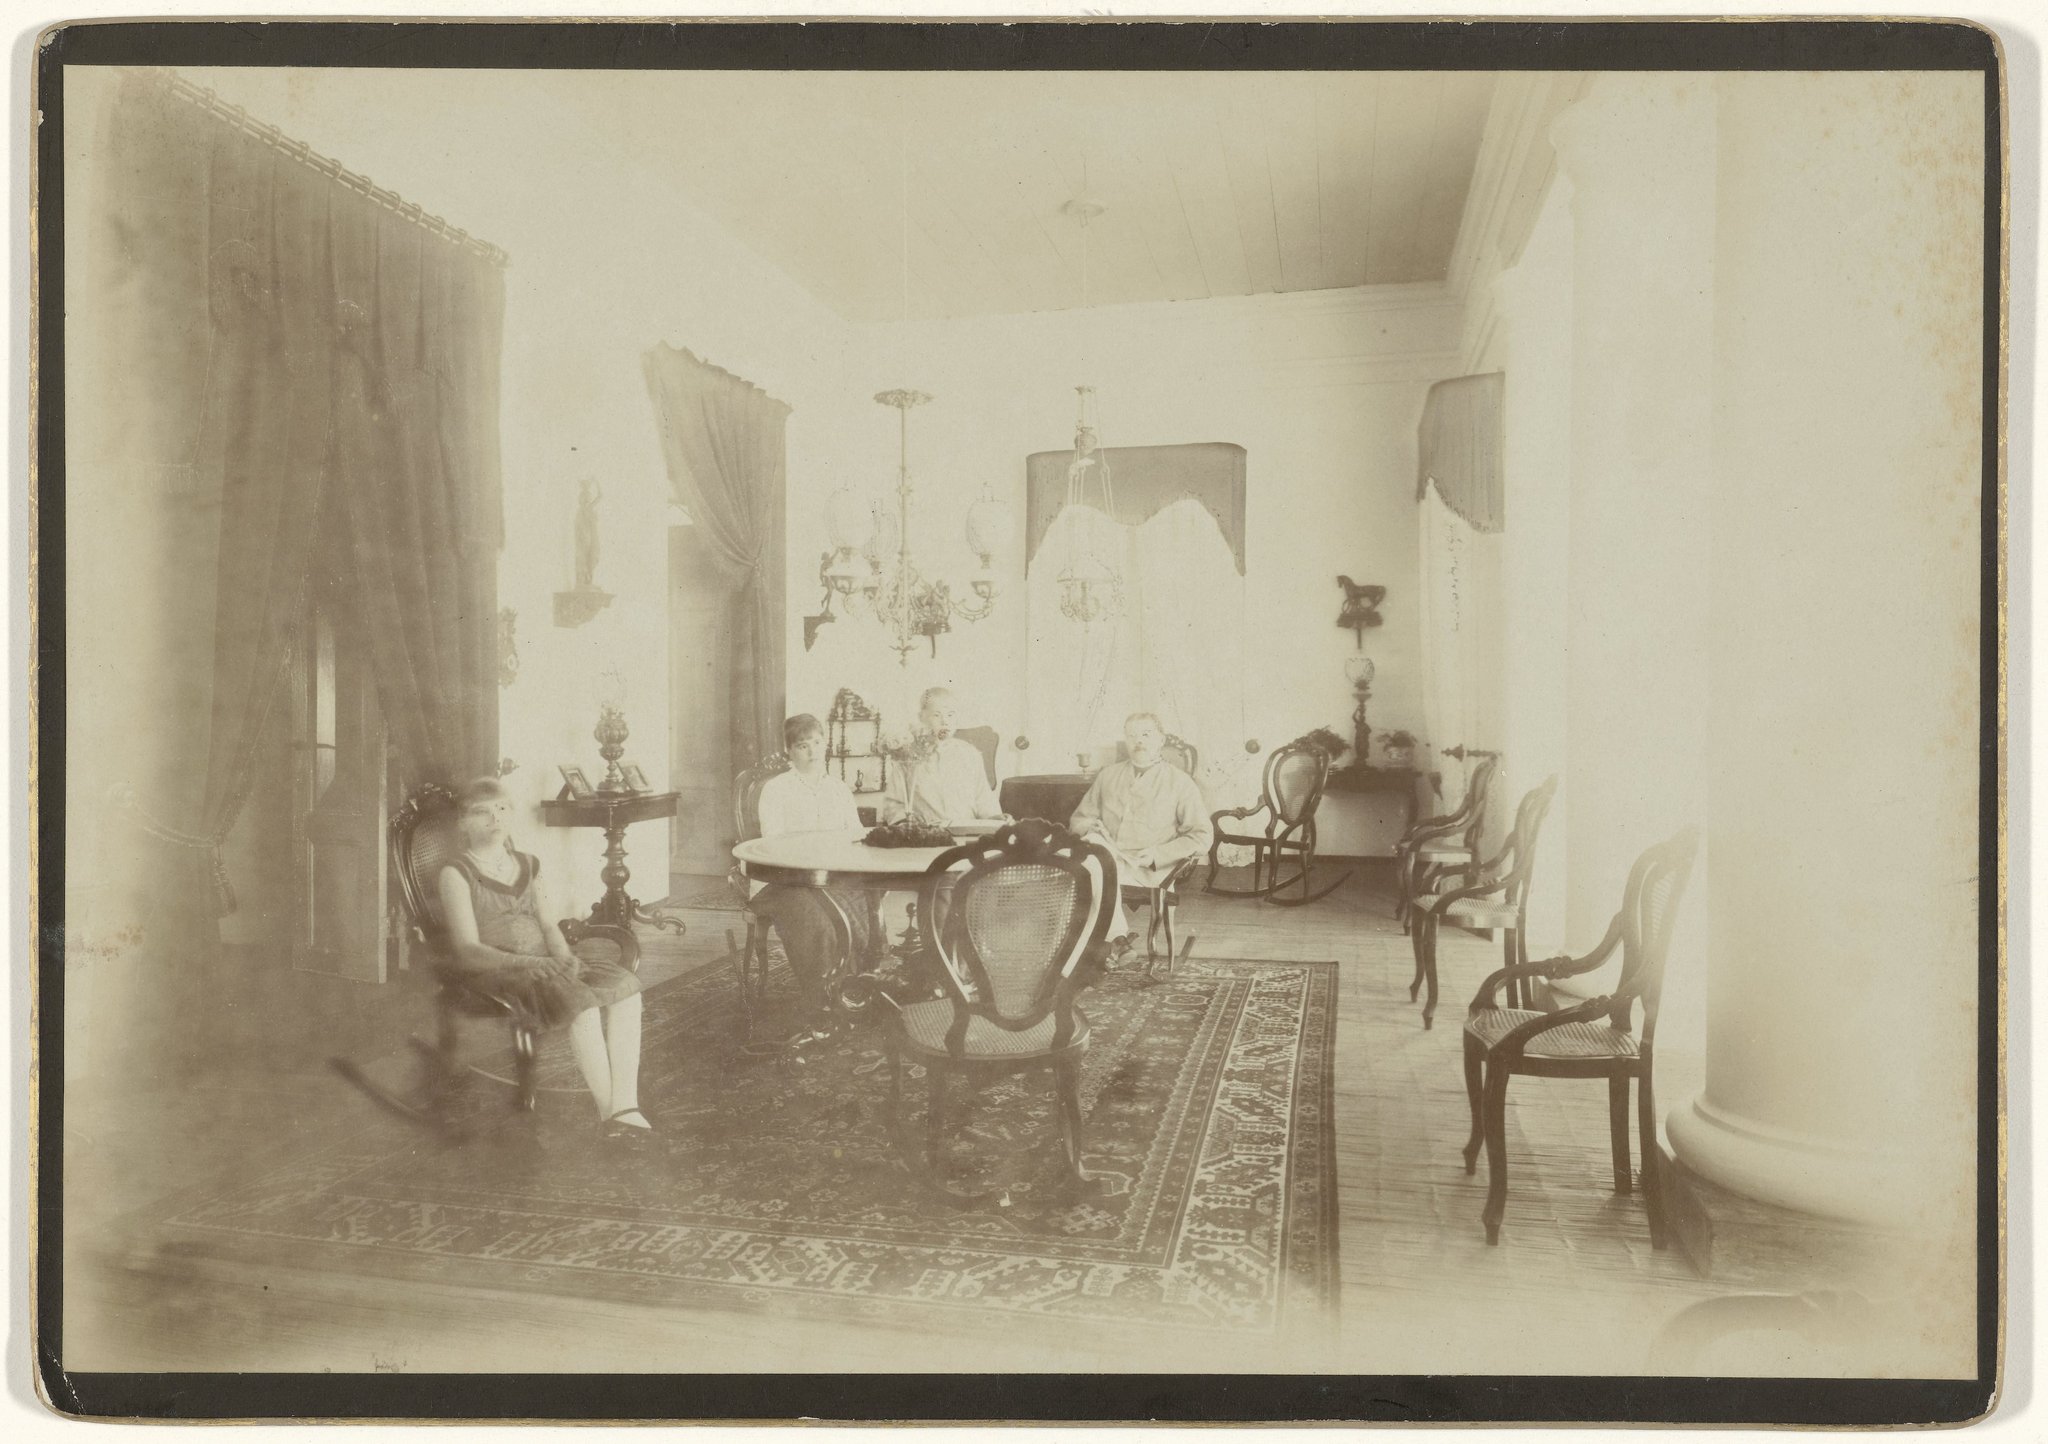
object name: photograph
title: Groepsportret van een onbekend gezin in een interieur, waarschijnlijk in Nederlands-Indië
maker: Anonymous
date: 1870-1890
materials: cardboard, paper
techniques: albumen print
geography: dutch east indies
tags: family group, especially parents with their child(ren), anonymous historical person portrayed, family life at home, living-room, parlour, sitting-room, dutch east indies, the